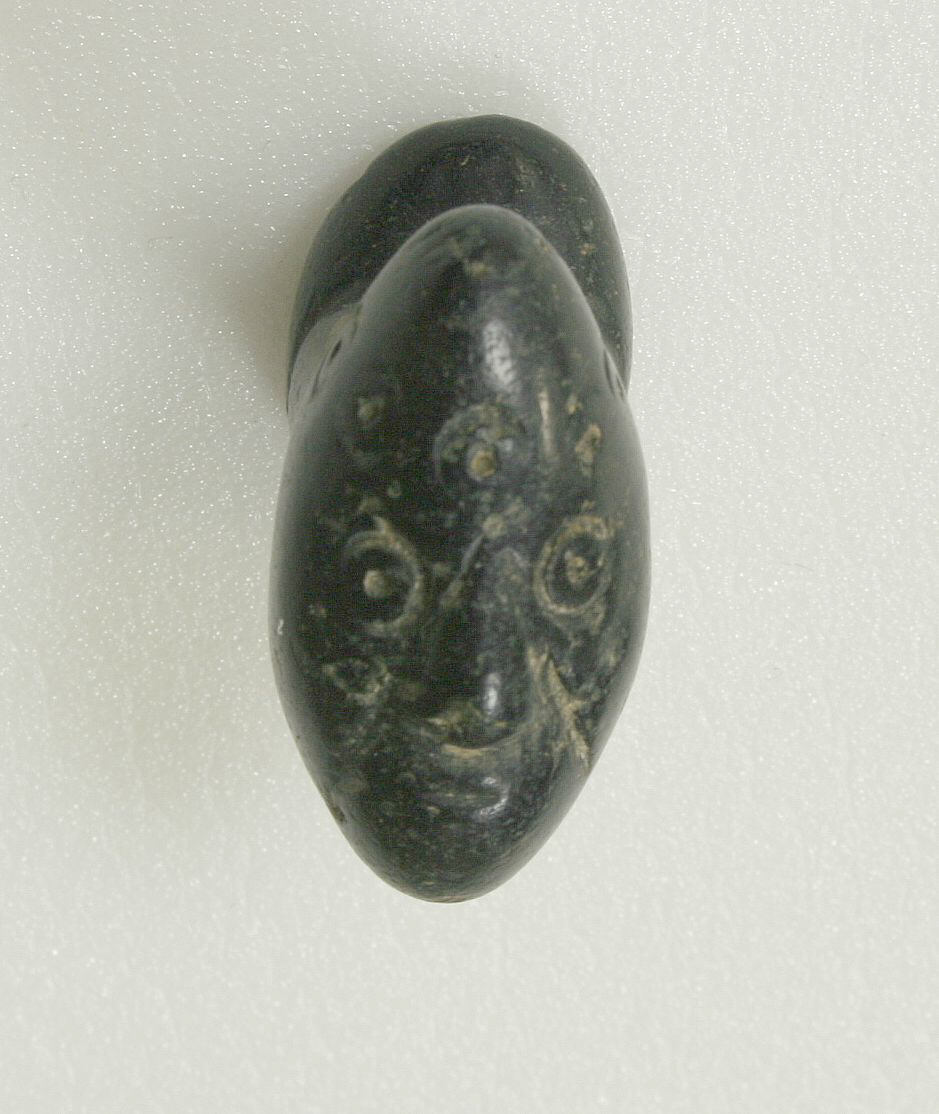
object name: labret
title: Elongated Stone Labret with Face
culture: peruvian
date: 1401-1500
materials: stone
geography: peru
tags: faces